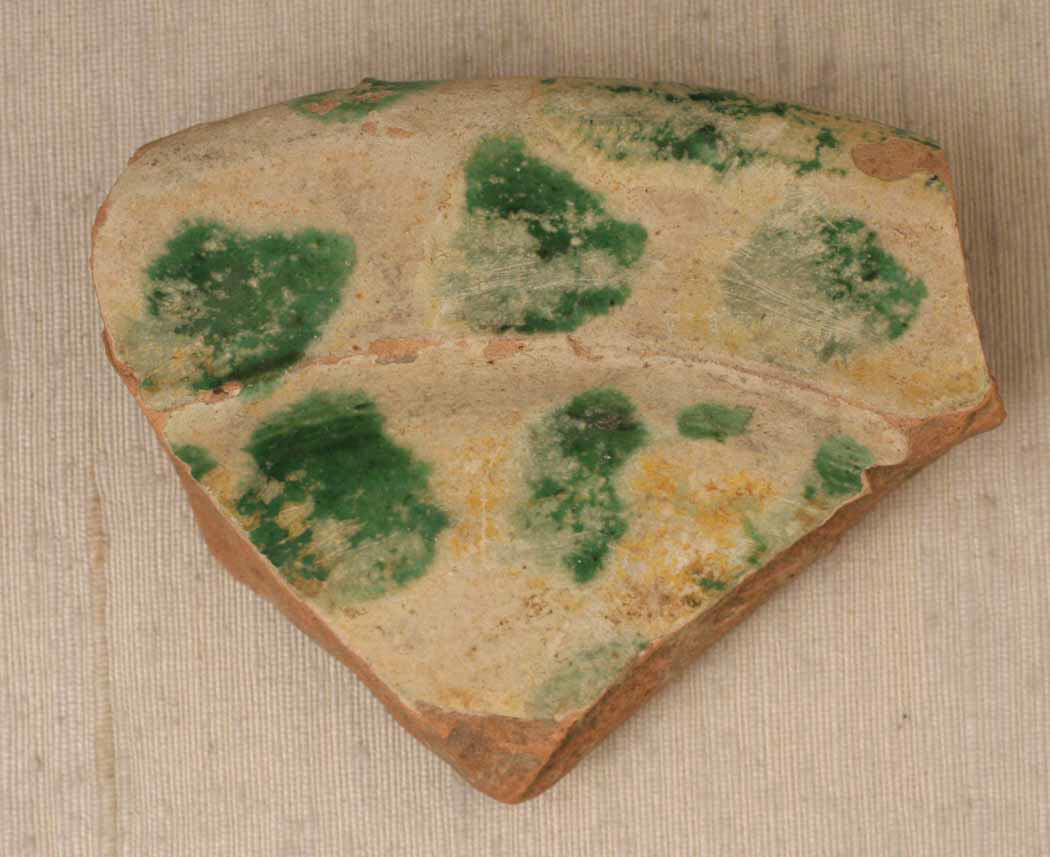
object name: fragment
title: Ceramic Fragment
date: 701-900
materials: earthenware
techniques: glazing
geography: iraq